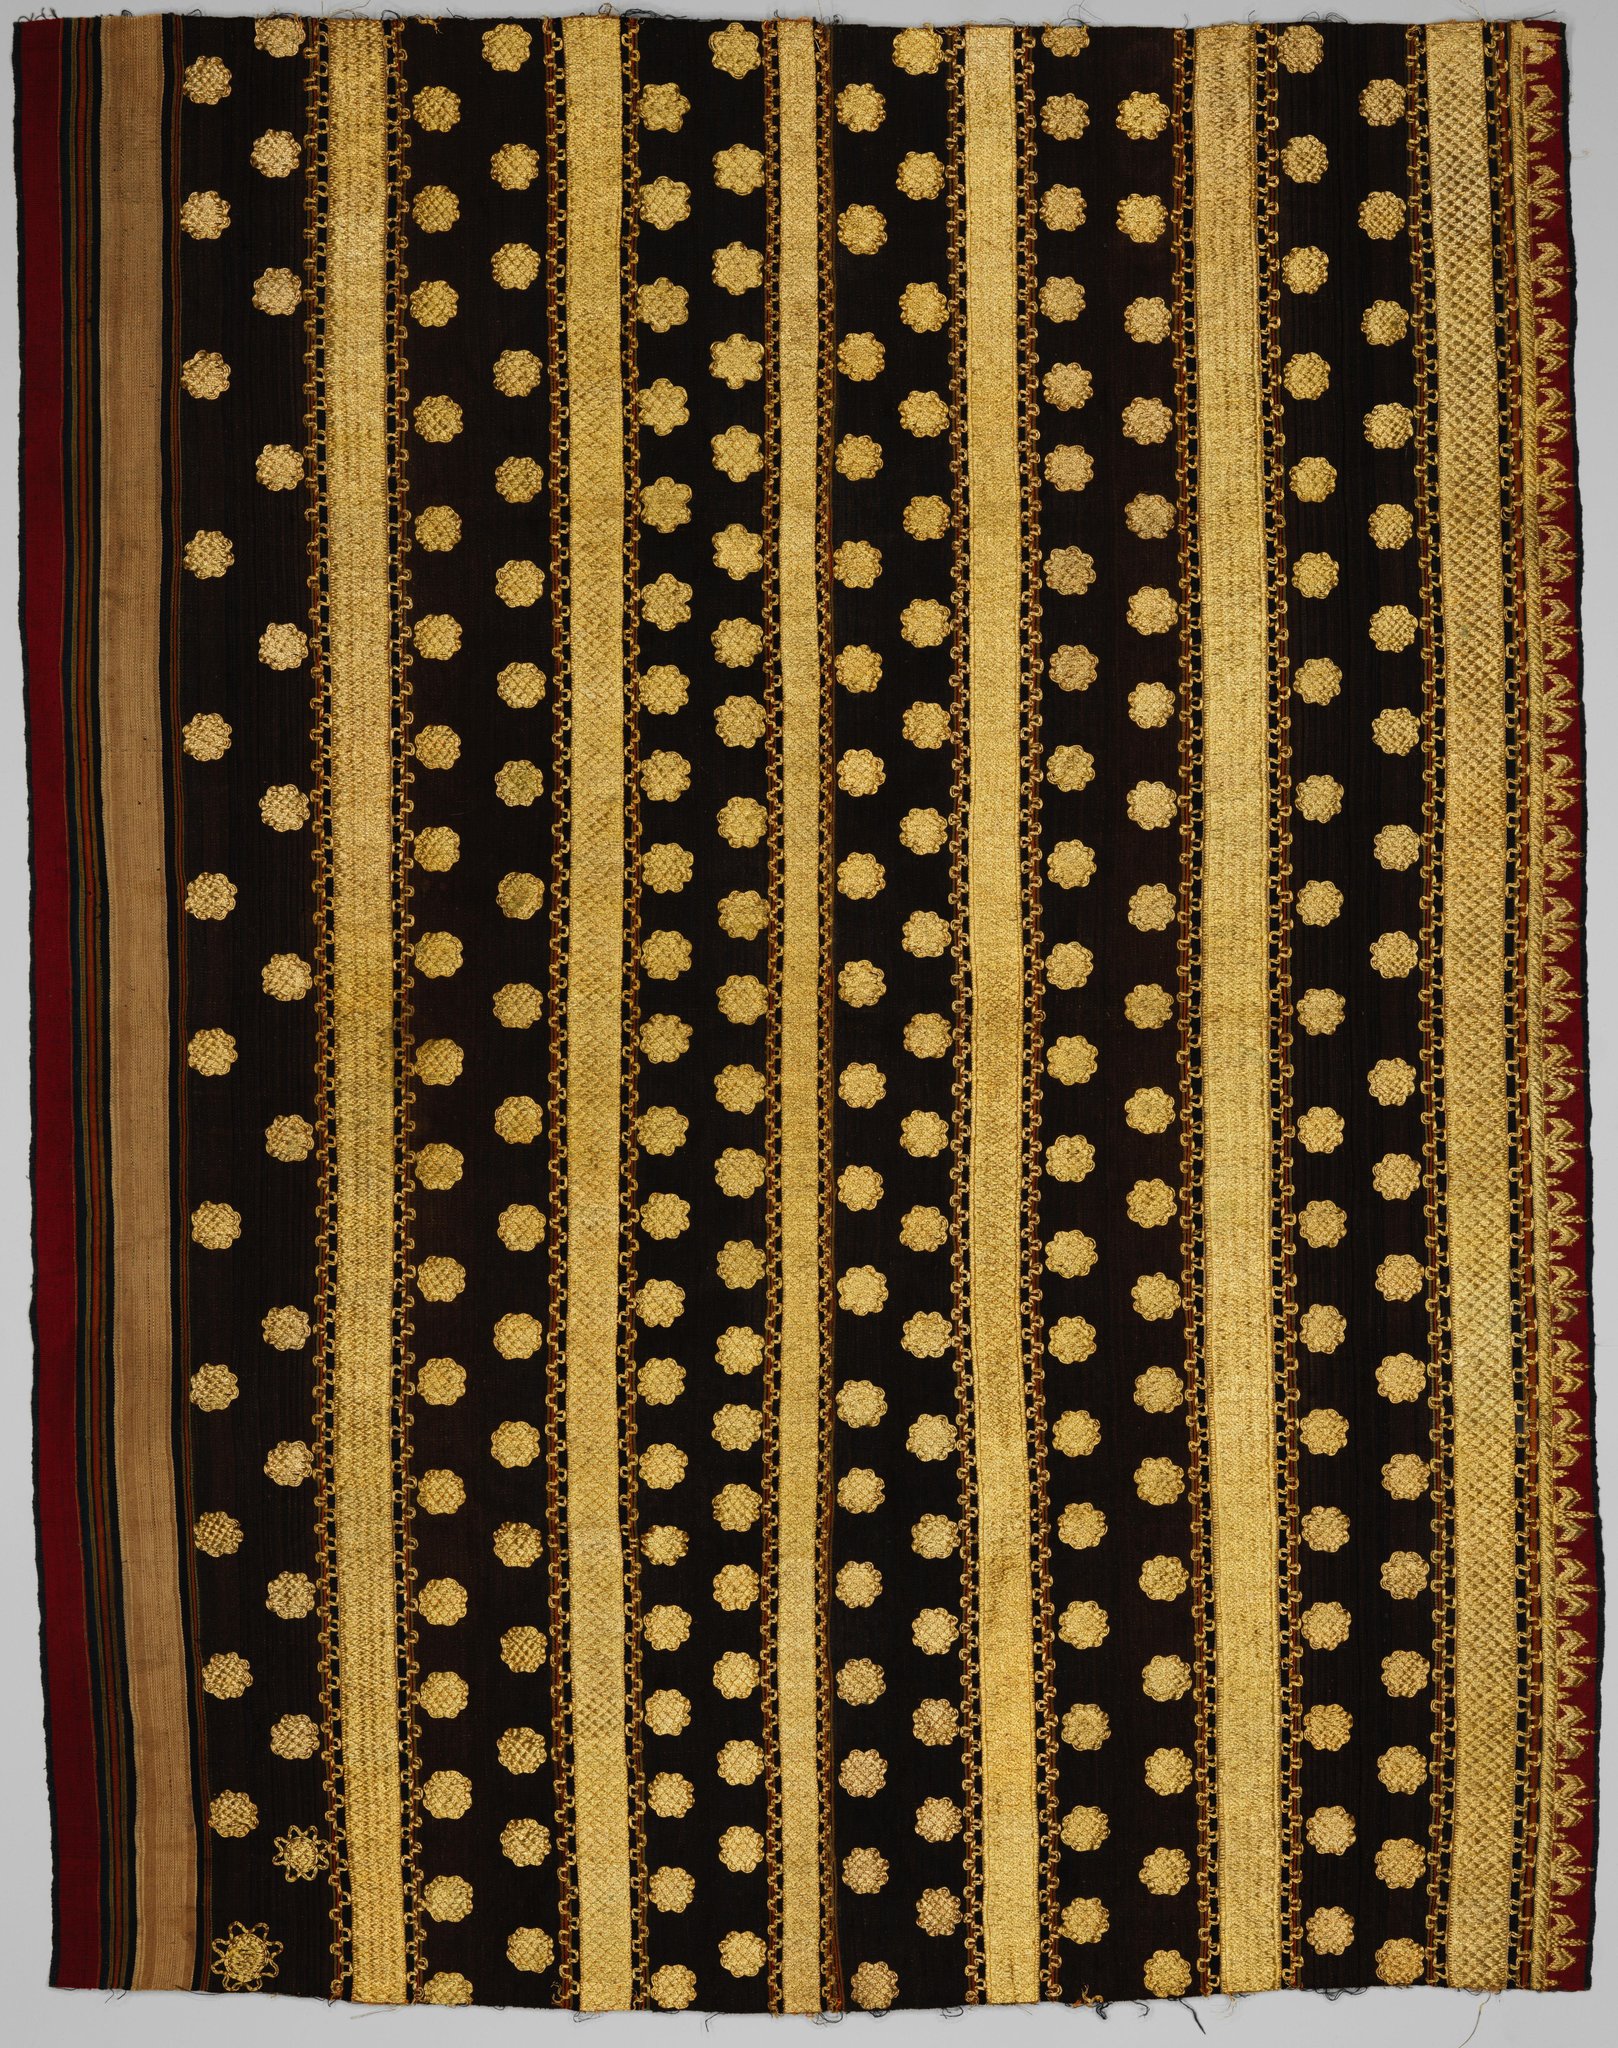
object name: cloth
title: Doek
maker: Anonymous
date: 1900-1999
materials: cotton, gold thread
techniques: weave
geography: sumatra